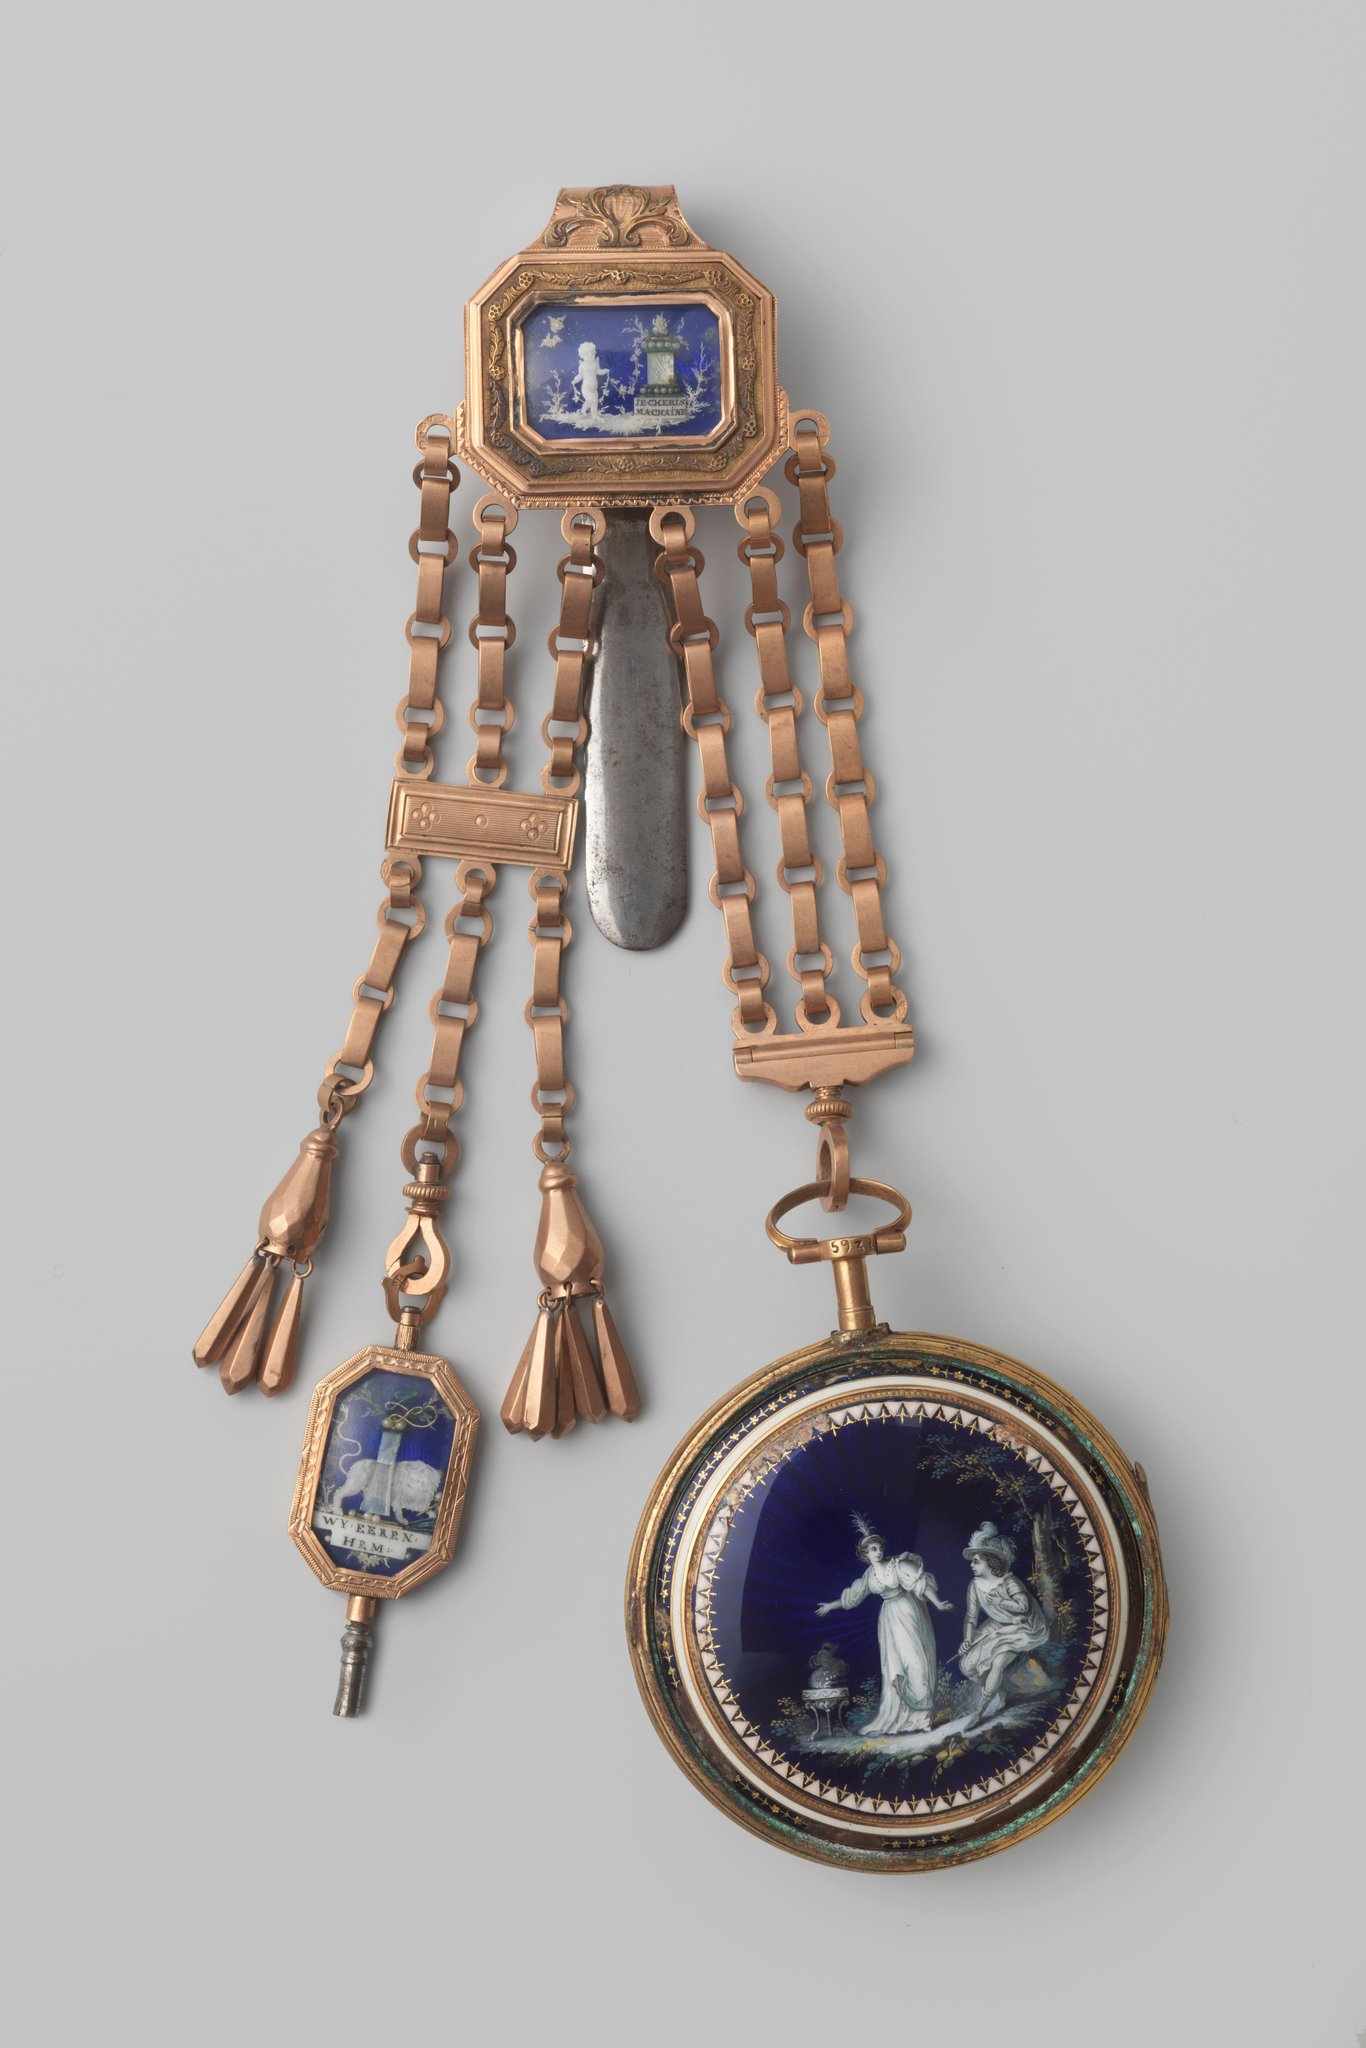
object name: jewellery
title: Chatelaine van rood goud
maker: Anonymous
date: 1885-1900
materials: gold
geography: netherlands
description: Chatelaine van roodgoud met 6 (?) kettingen waaraan een horlogesleutel met medaillon. Op de haak een medaillon met een amoret.